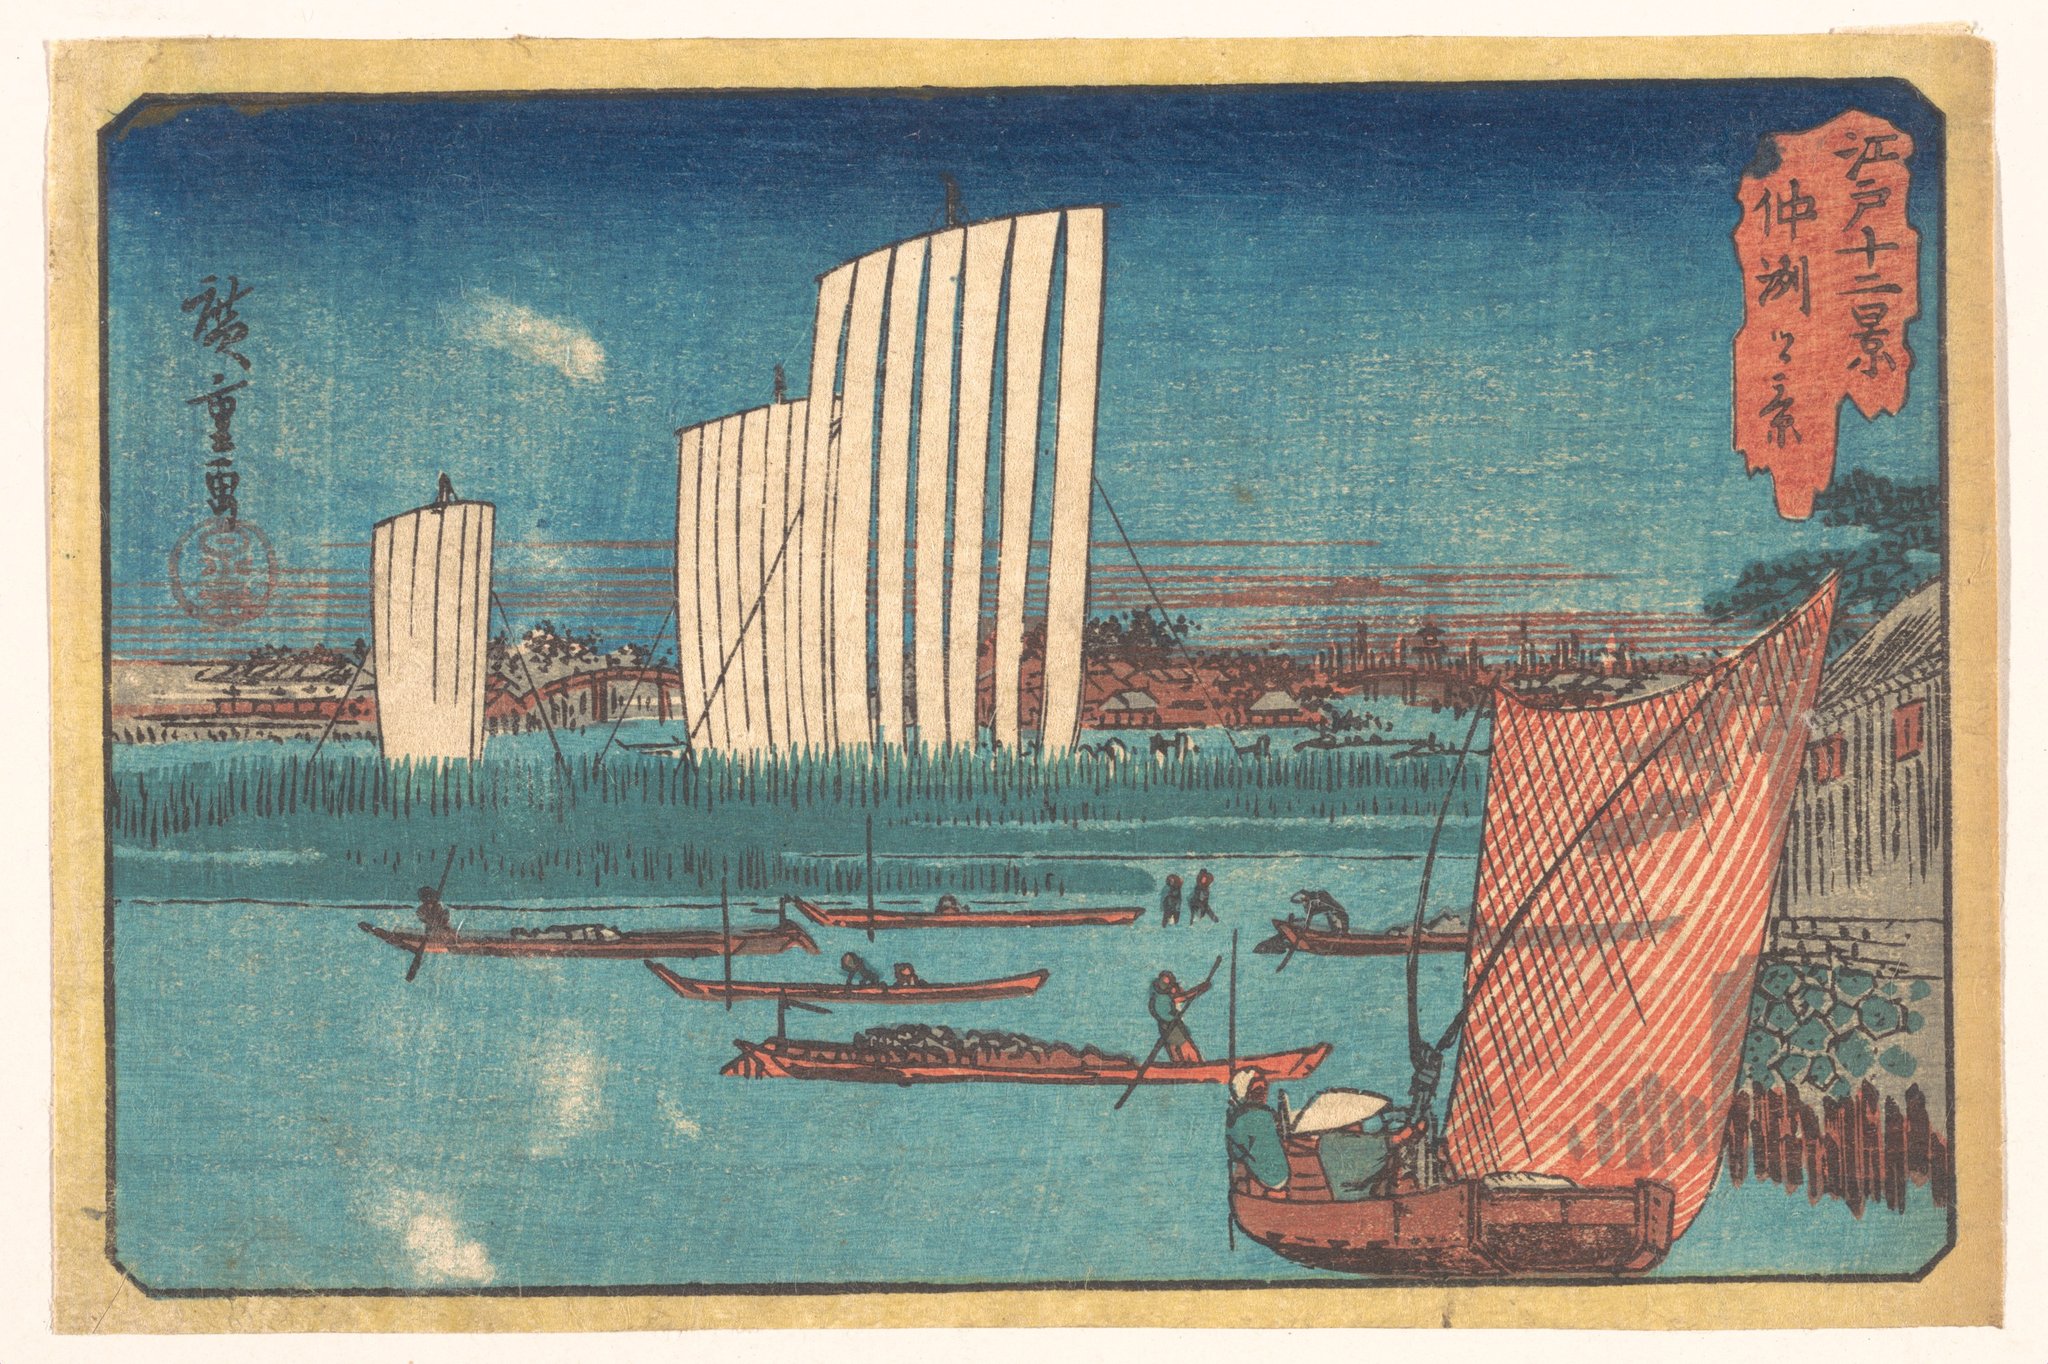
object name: print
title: 江戸十二景 仲洲之景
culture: japanese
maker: utagawa hiroshige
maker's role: artist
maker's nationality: japanese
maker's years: 1797-1858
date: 1797-1858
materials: ink, paper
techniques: woodblock print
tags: landscapes,boats